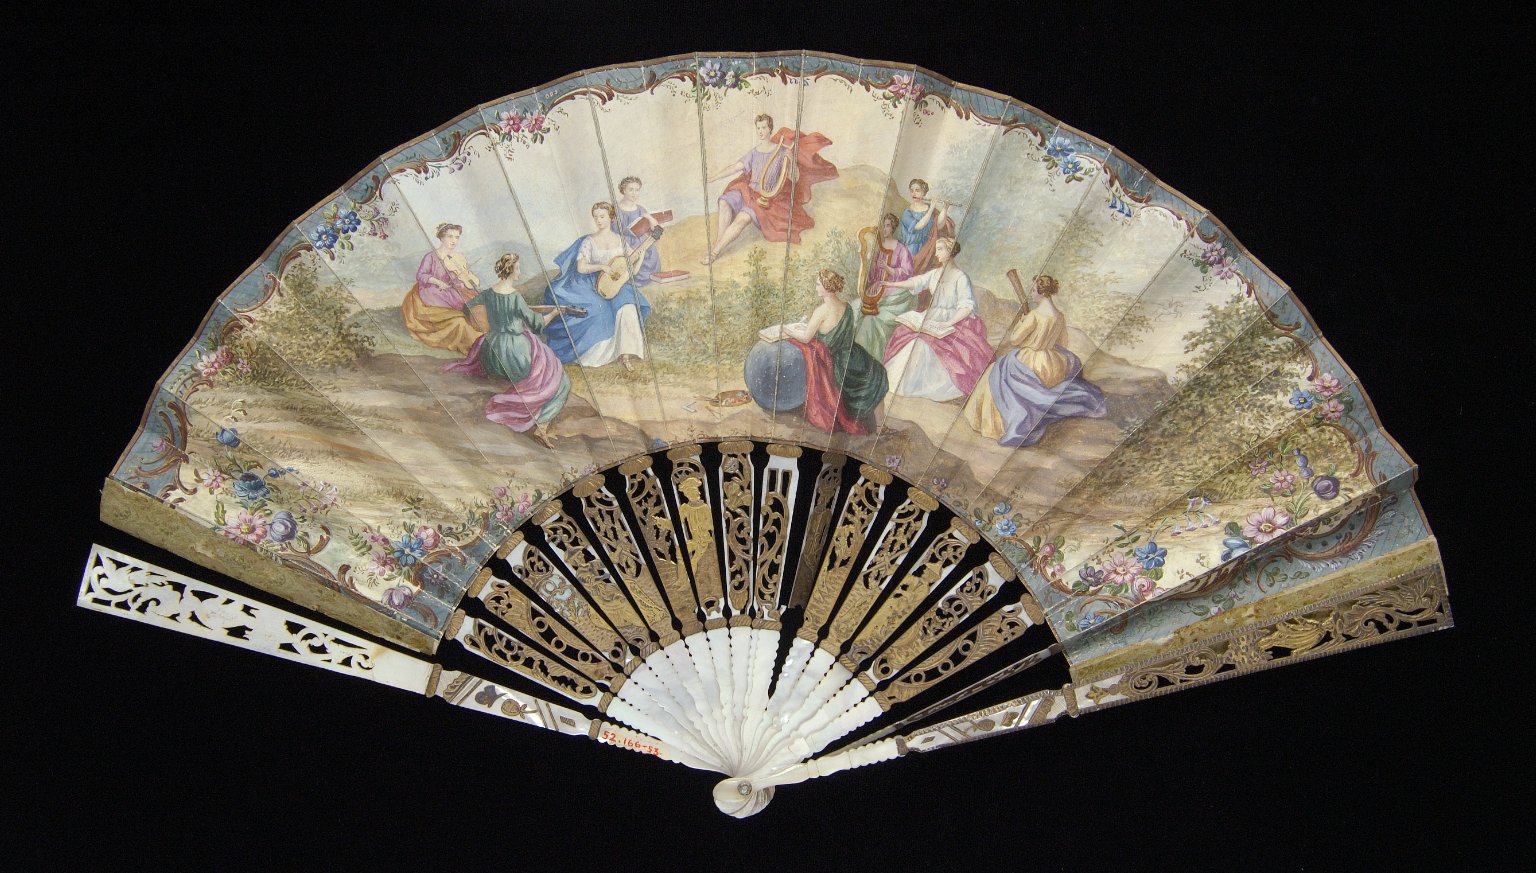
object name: fan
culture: french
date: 1851-1875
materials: glass, mother of pearl, paper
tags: musical instruments,women,musicians